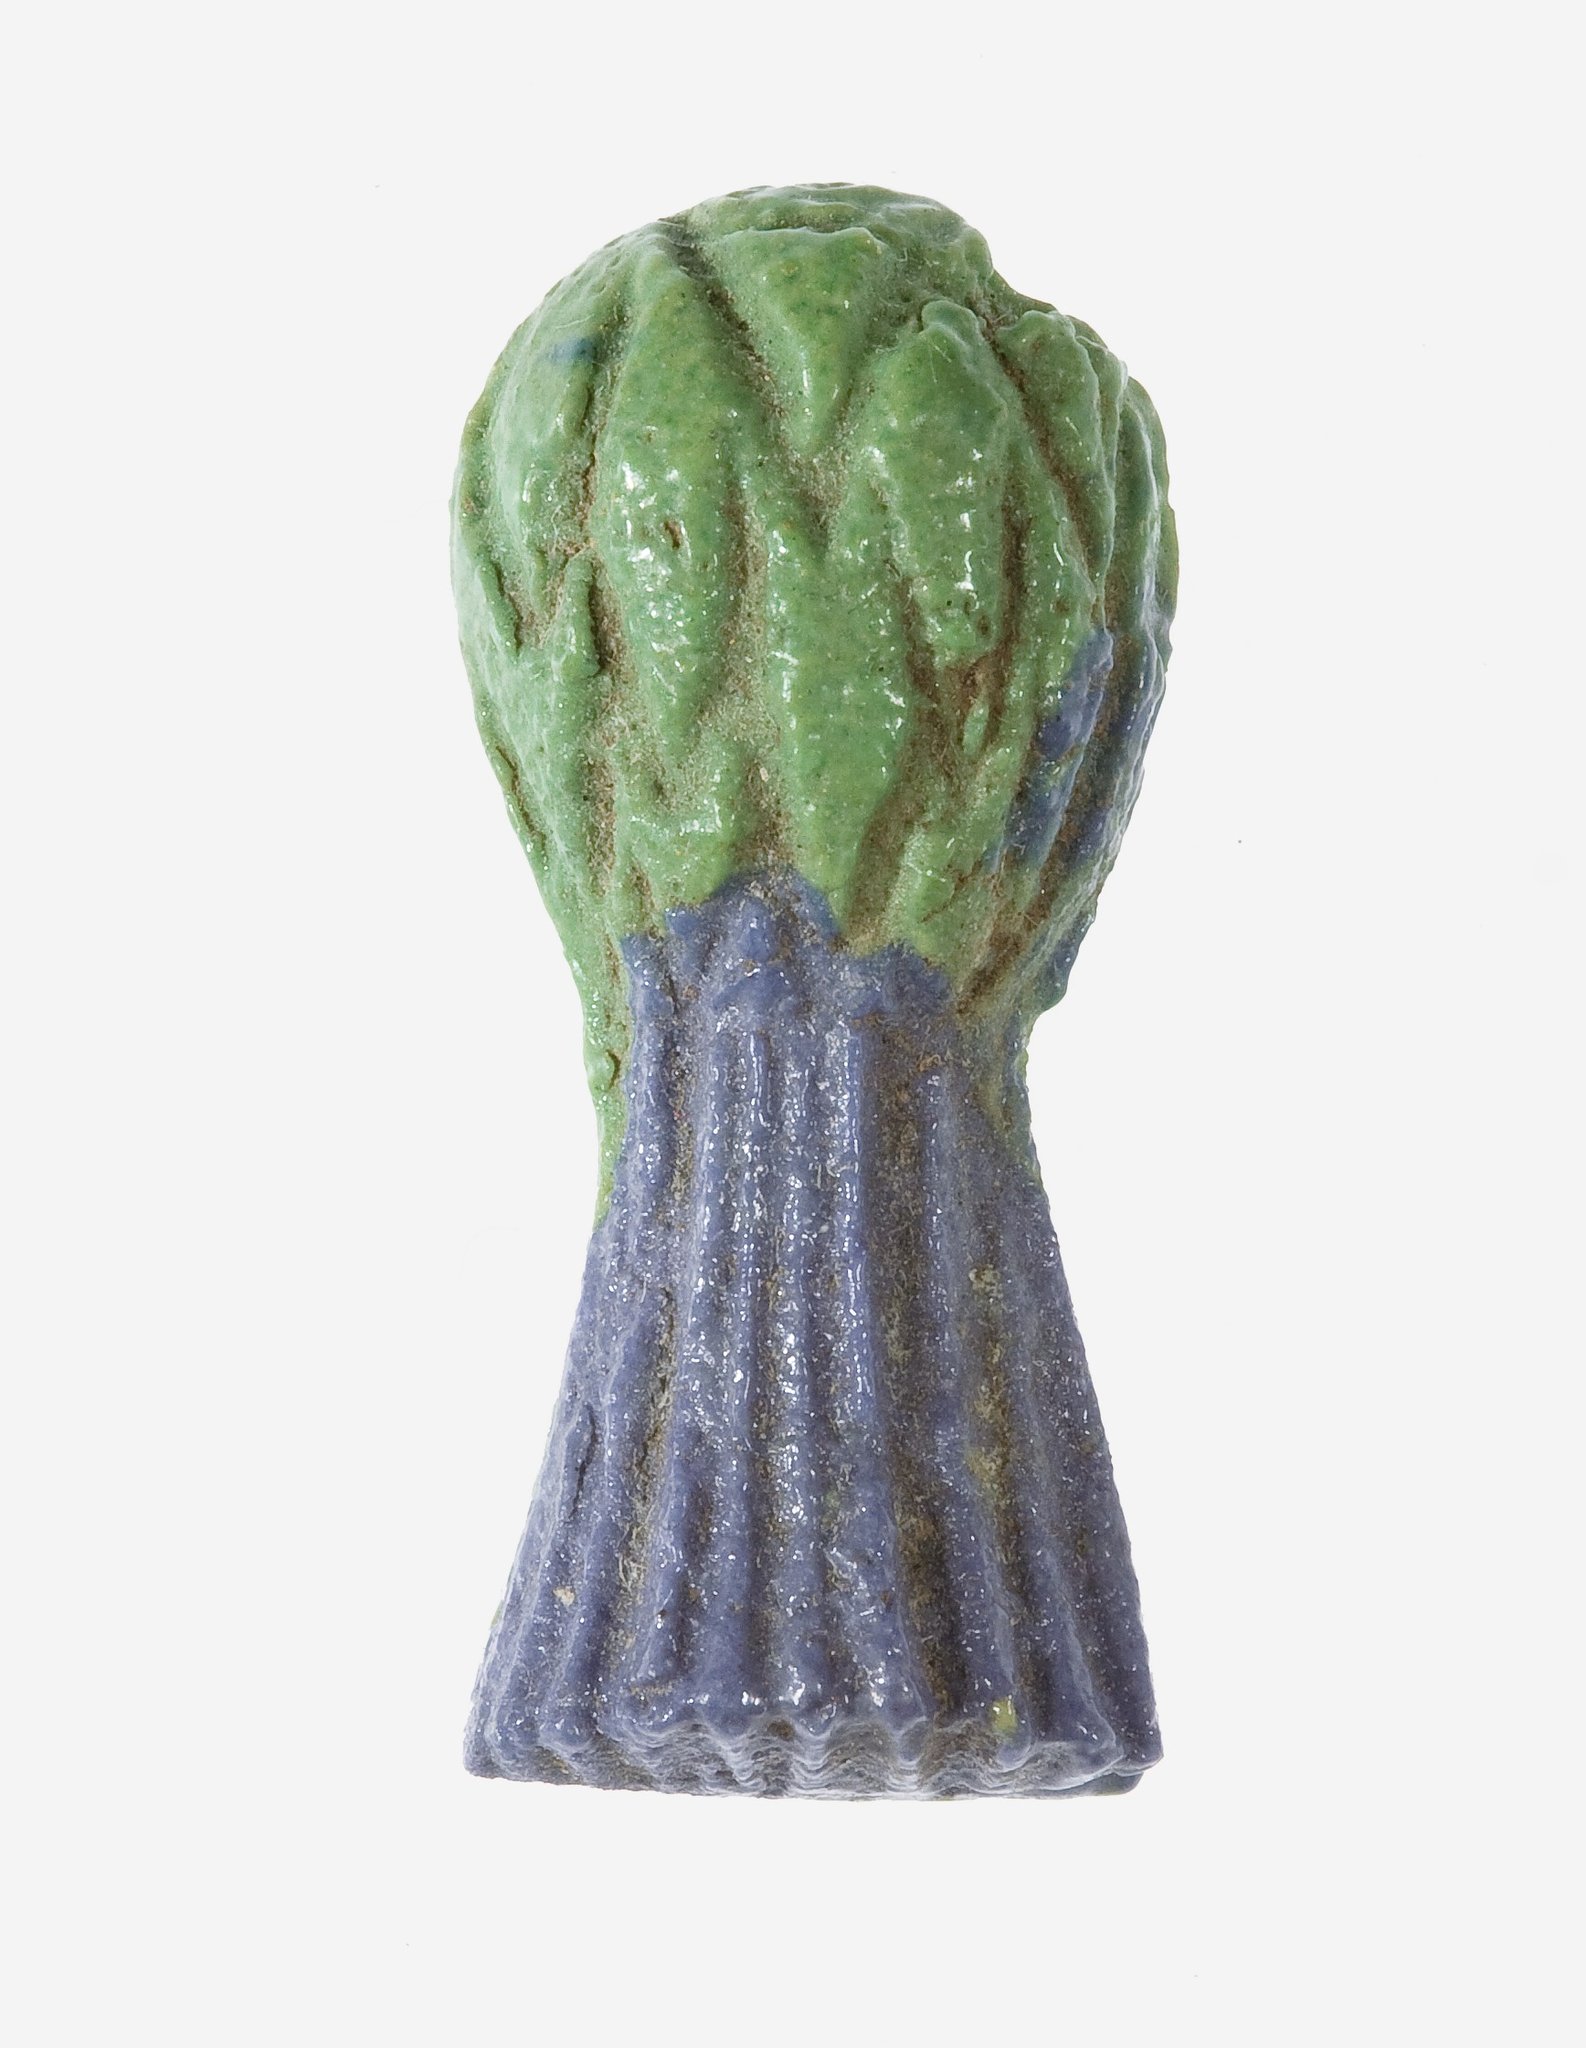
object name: bead, cornflower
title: Cornflower Bead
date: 1390-1352 BCE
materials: faience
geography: egypt